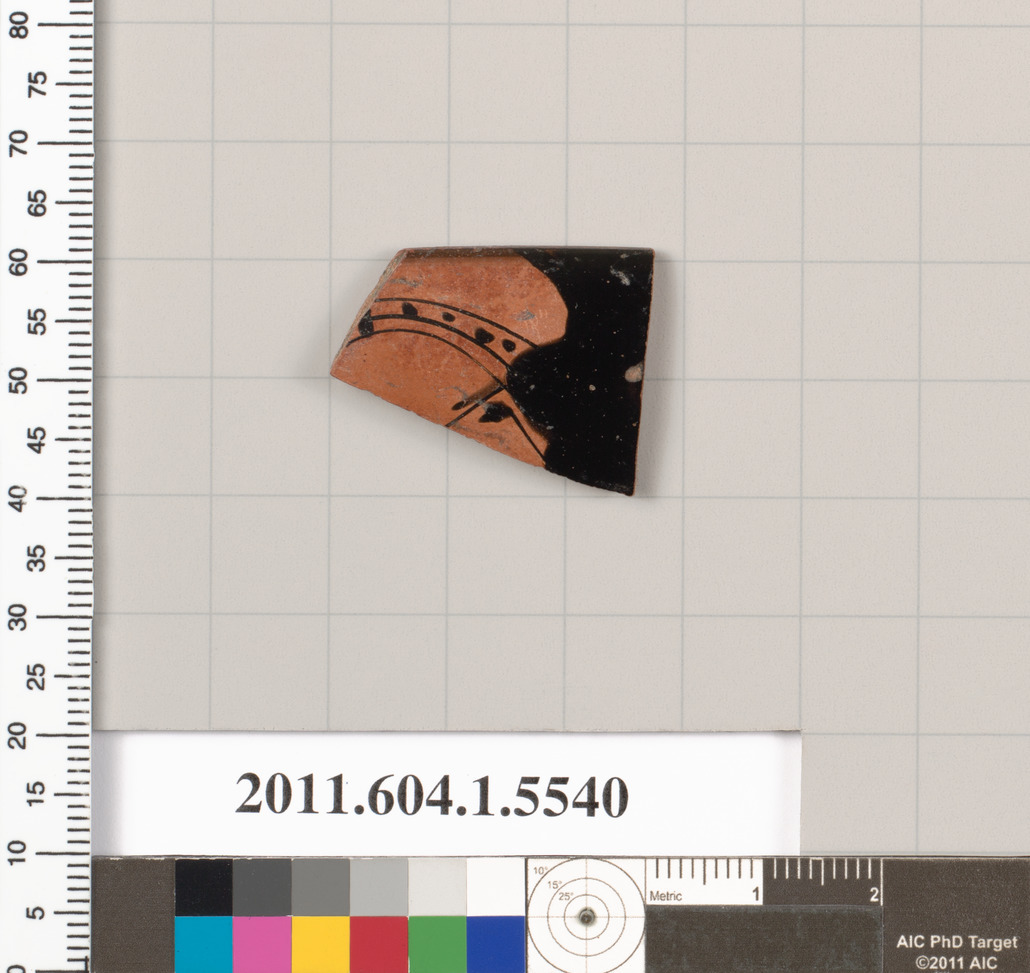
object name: kylix fragment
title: Terracotta rim fragment of a kylix (drinking cup)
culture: greek, attic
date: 510-500 BCE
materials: terracotta